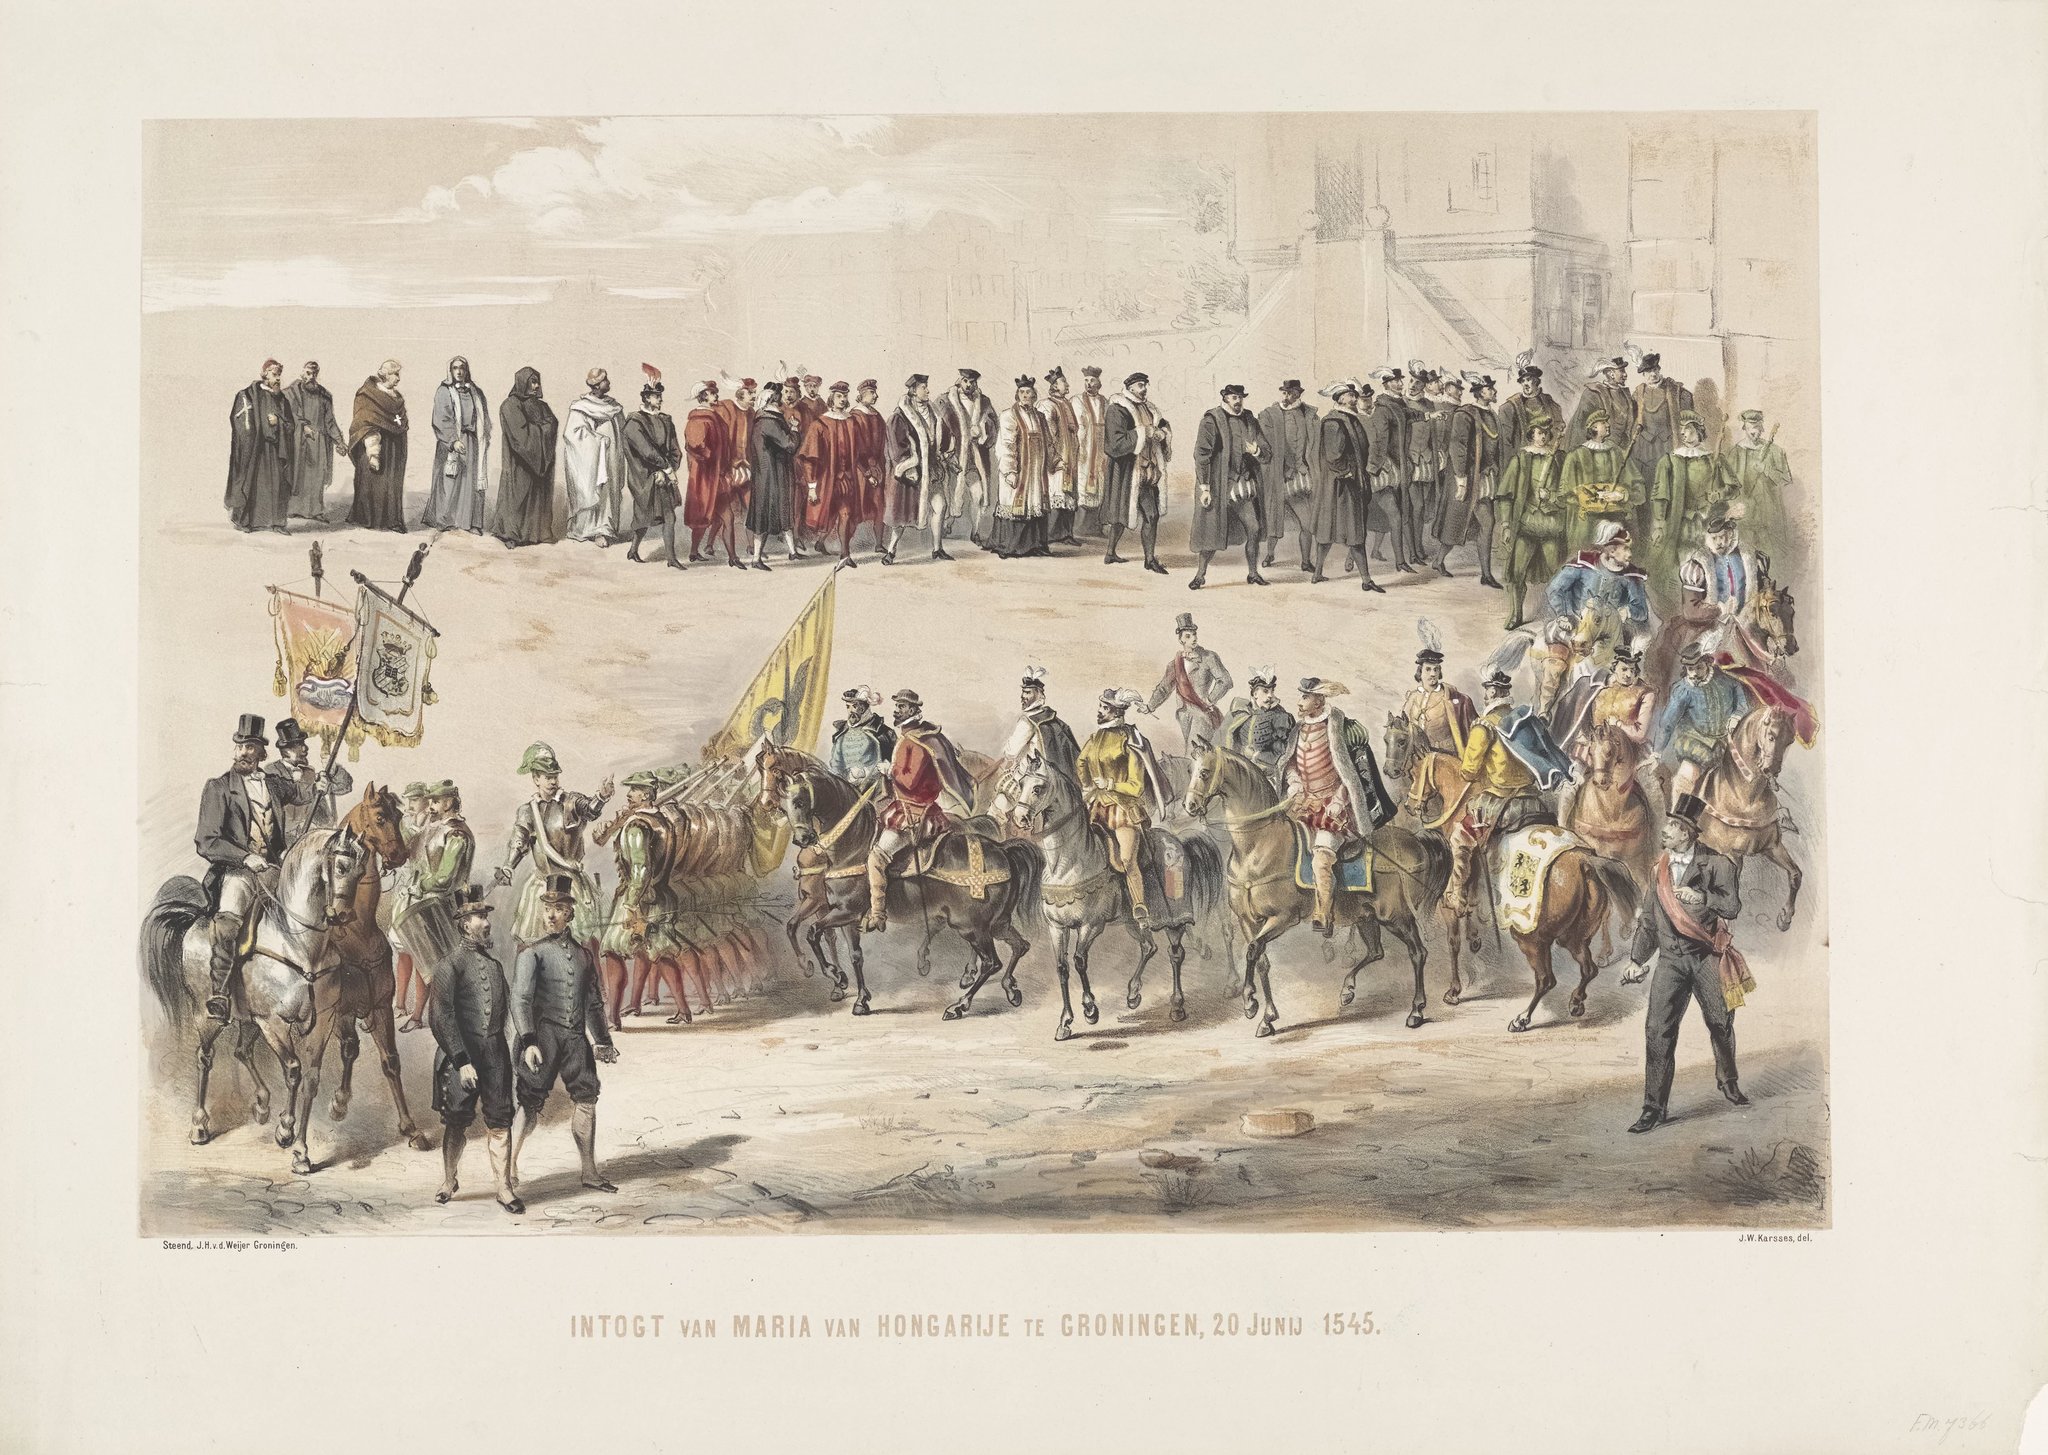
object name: print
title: Groningse maskerade (eerste groep), 1864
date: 1864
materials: paper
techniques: lithograph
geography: groningen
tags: brussels, maria van hongarije (landvoogdes der nederlanden), students' pageant, costumes used in pageants, commemoration of the founding of a university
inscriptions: collector's mark: Lugt 2228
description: Eerste groep van de gekostumeerde optocht georganiseerd door de studenten van de Hogeschool van Groningen op 14 september 1864, ter viering van het 250-jarig bestaan van de hogeschool, voorstellende de intocht van Maria van Hongarije in Groningen op 20 juni 1545.